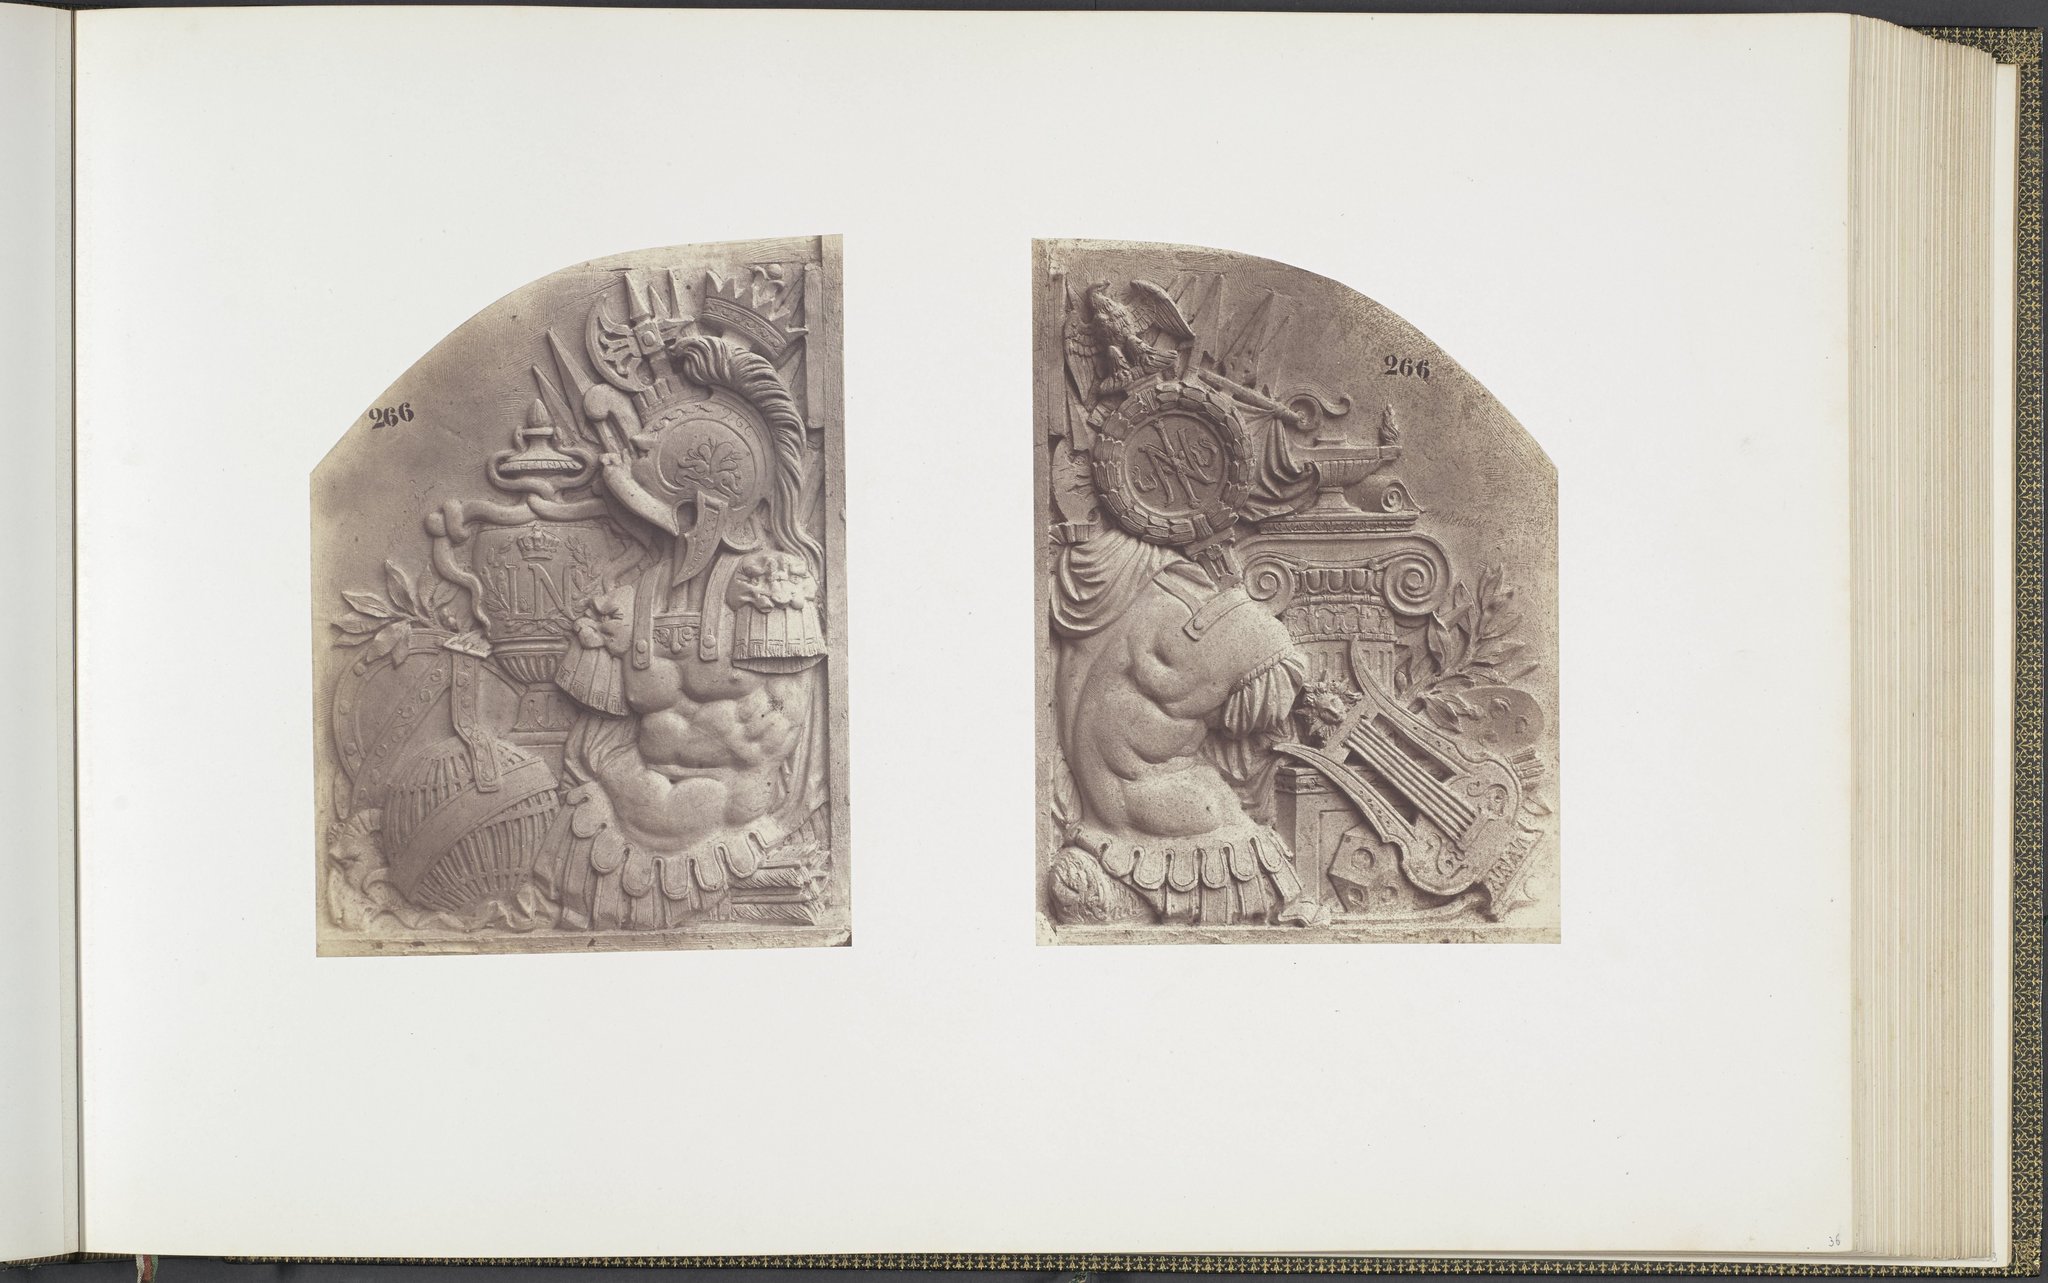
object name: photograph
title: Gipsmodellen voor beeldhouwwerken op het Palais du Louvre: links "Trophée d'armes" door Ambroise Choiselat en rechts "Trophée d'armes et d'attributs des arts" door Pierre Rouillard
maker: édouard denis baldus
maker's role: fotograaf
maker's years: 1813-1889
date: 1855-1857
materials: paper, photographic support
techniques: salted paper print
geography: paris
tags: piece of sculpture, reproduction of a piece of sculpture, permanent exhibition, museum, paris, tuileries palace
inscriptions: number: ‘266’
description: Onderdeel van Réunion des Tuileries au Louvre 1852-1857, album 1.